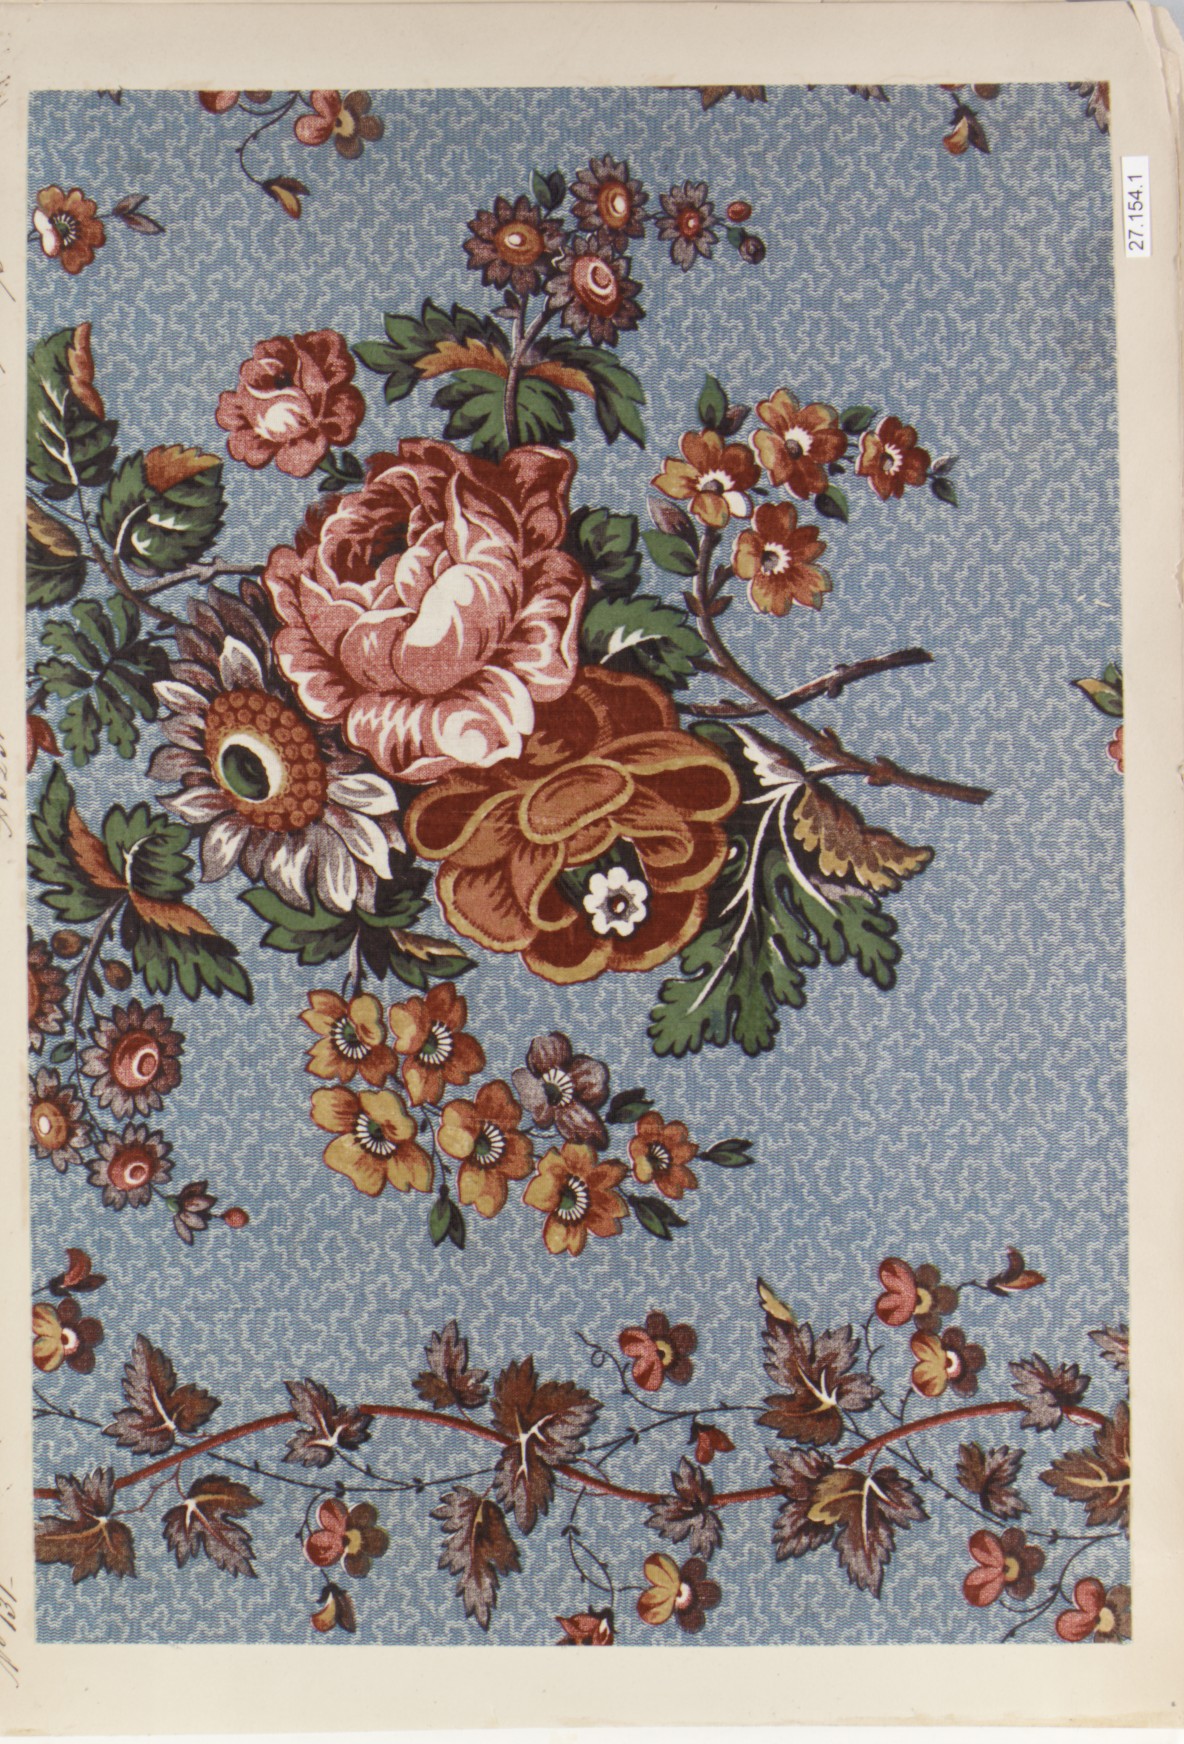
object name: sample book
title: Sample books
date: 1801-1900